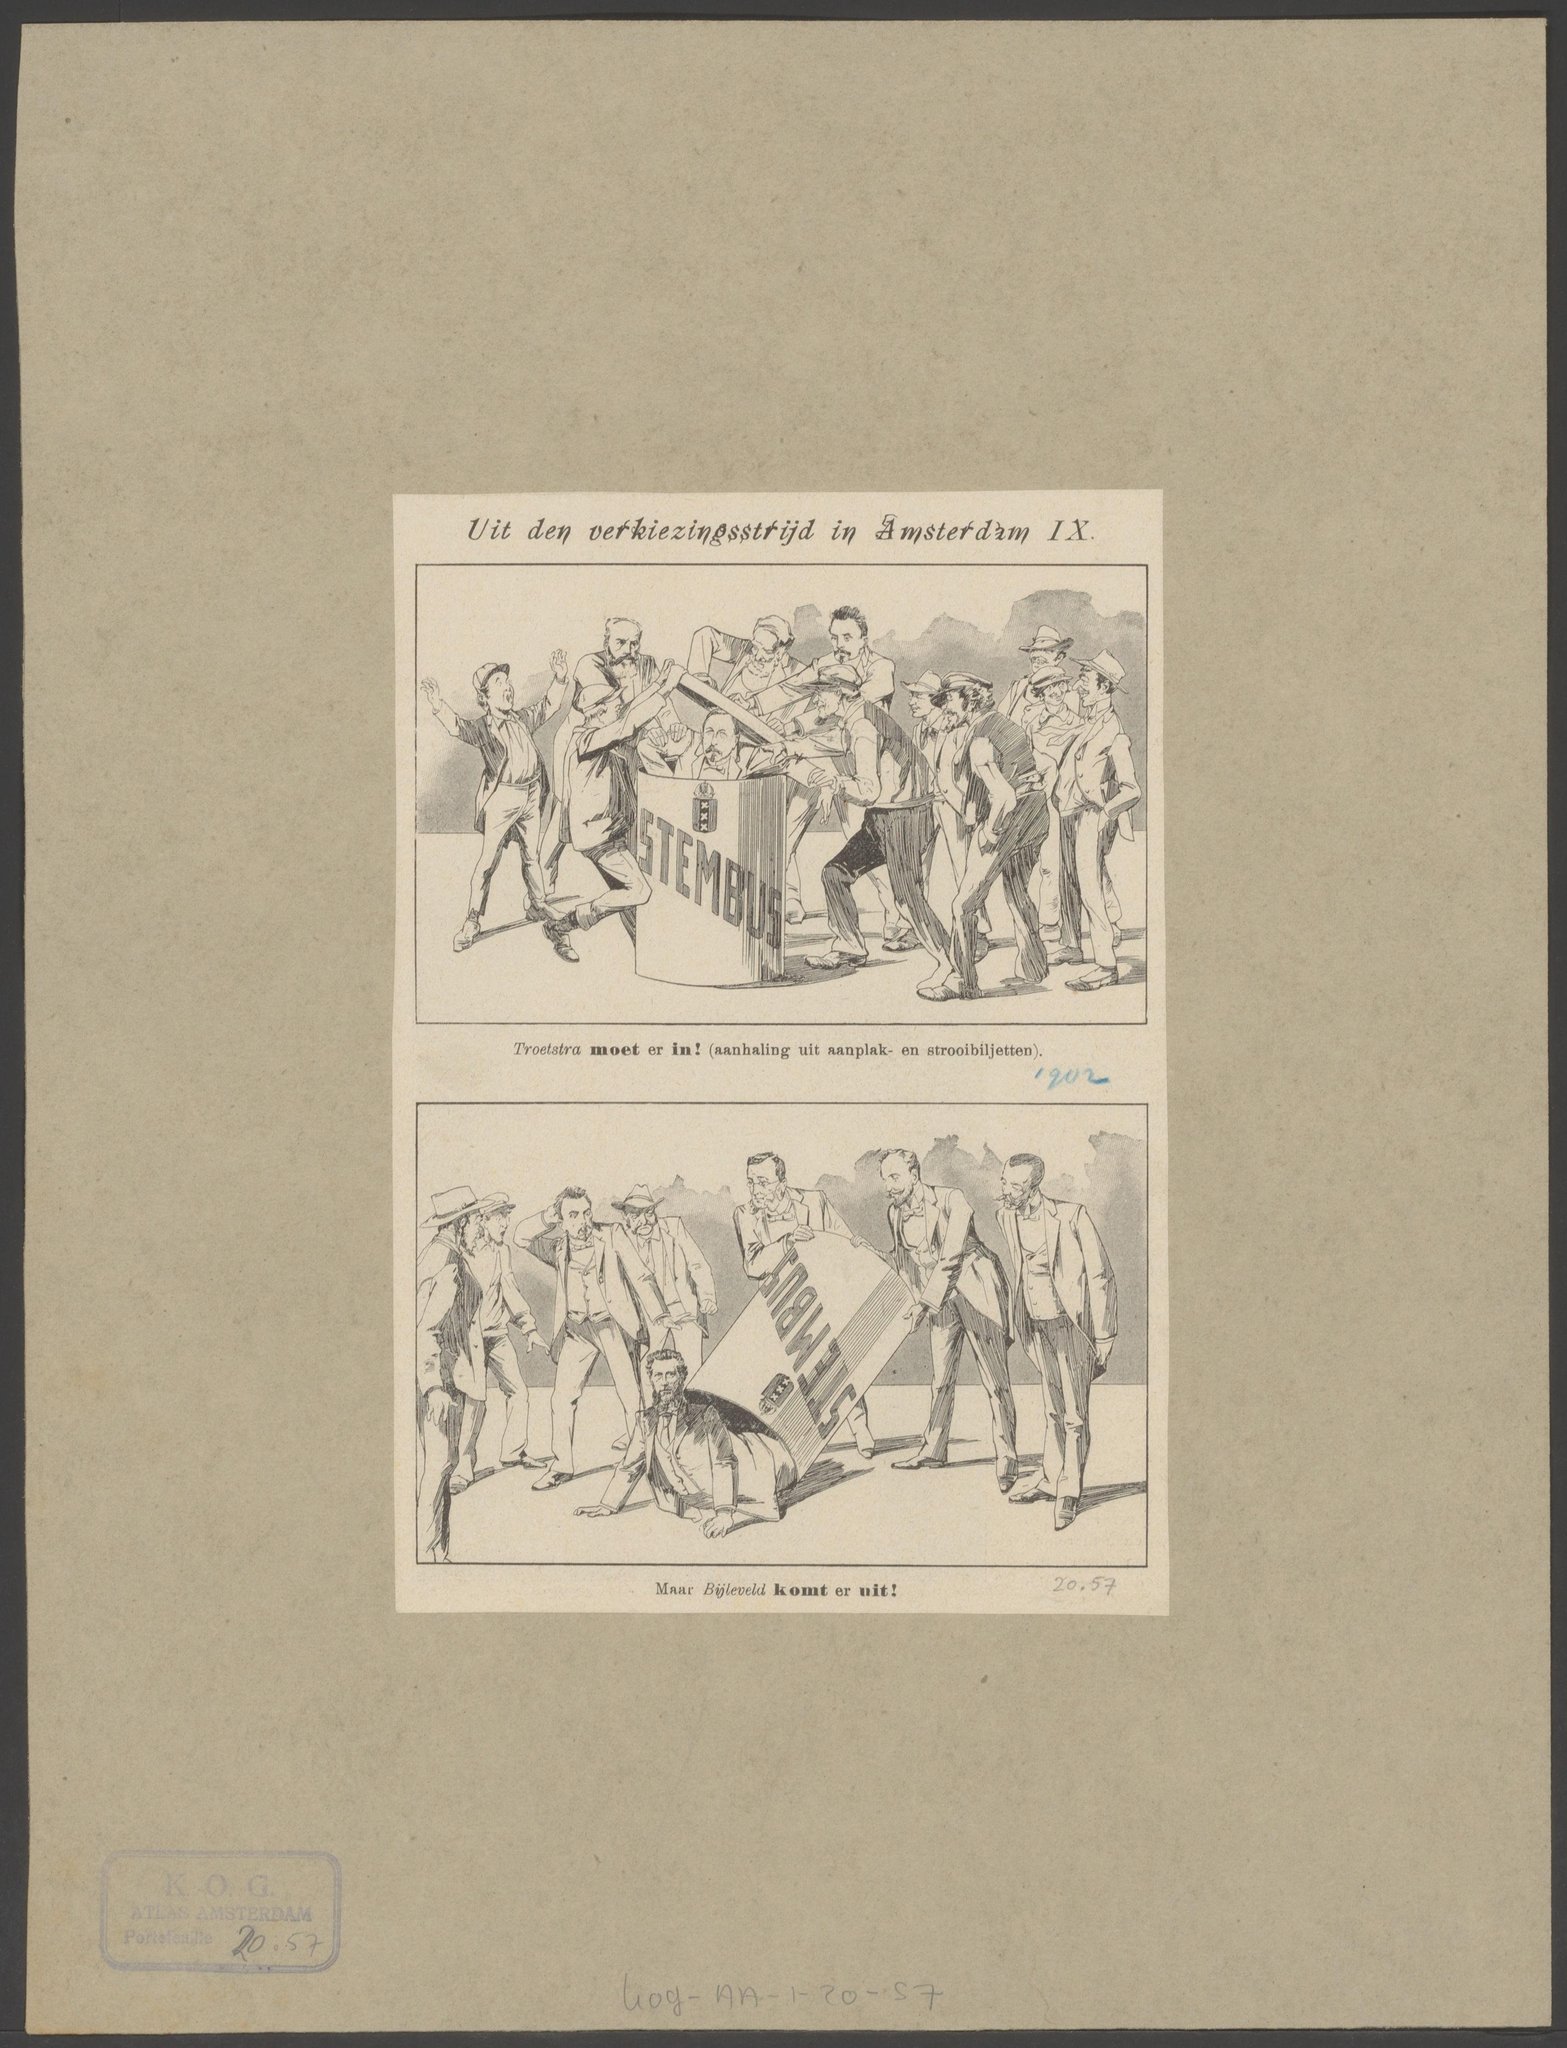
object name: cartoon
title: Uit den verkiezingsstrijd in Amsterdam IX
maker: Anonymous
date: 1902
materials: paper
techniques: letterpress printing, line block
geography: amsterdam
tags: utrecht, haarlem, politician, coat of arms (as symbol of the state, etc.) (+ city; municipal), voting, election, voting receptacle, politician, e.g. party leader, political caricatures and satires, amsterdam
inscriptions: collector's mark: Lugt 1641b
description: Prent uit: Geïllustreerd Zondagsblad voor Katholieken, 28 september 1902.